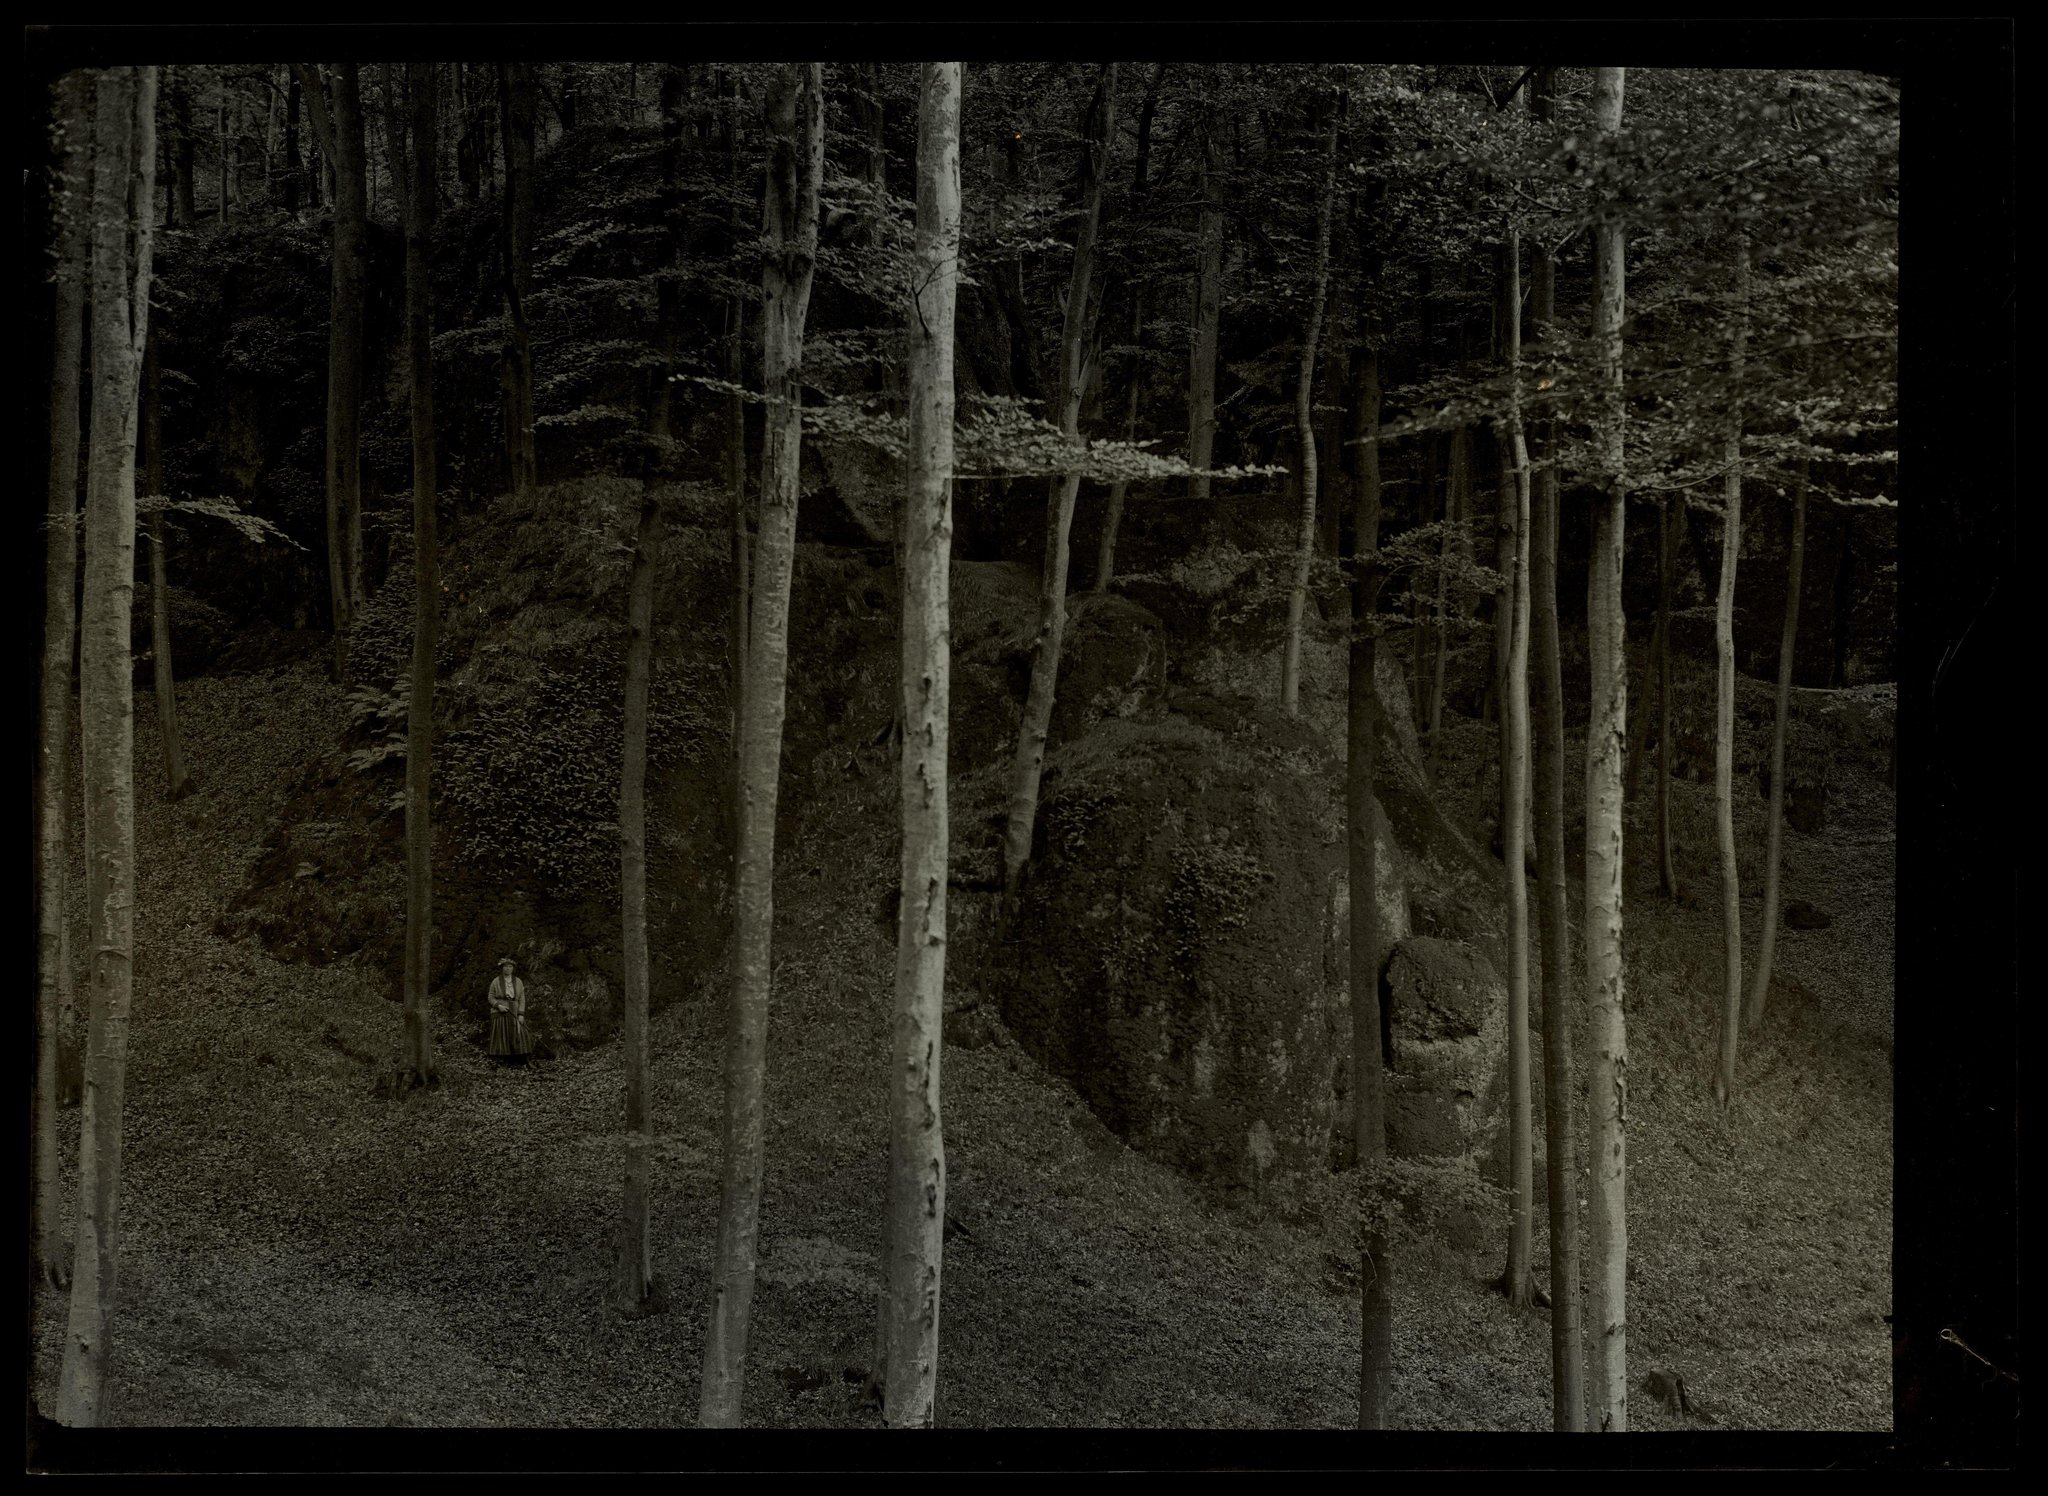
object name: negative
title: Filmnegatief met opname van Eisenach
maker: Anonymous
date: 1921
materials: film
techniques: gelatin silver negative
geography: germany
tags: eisenach